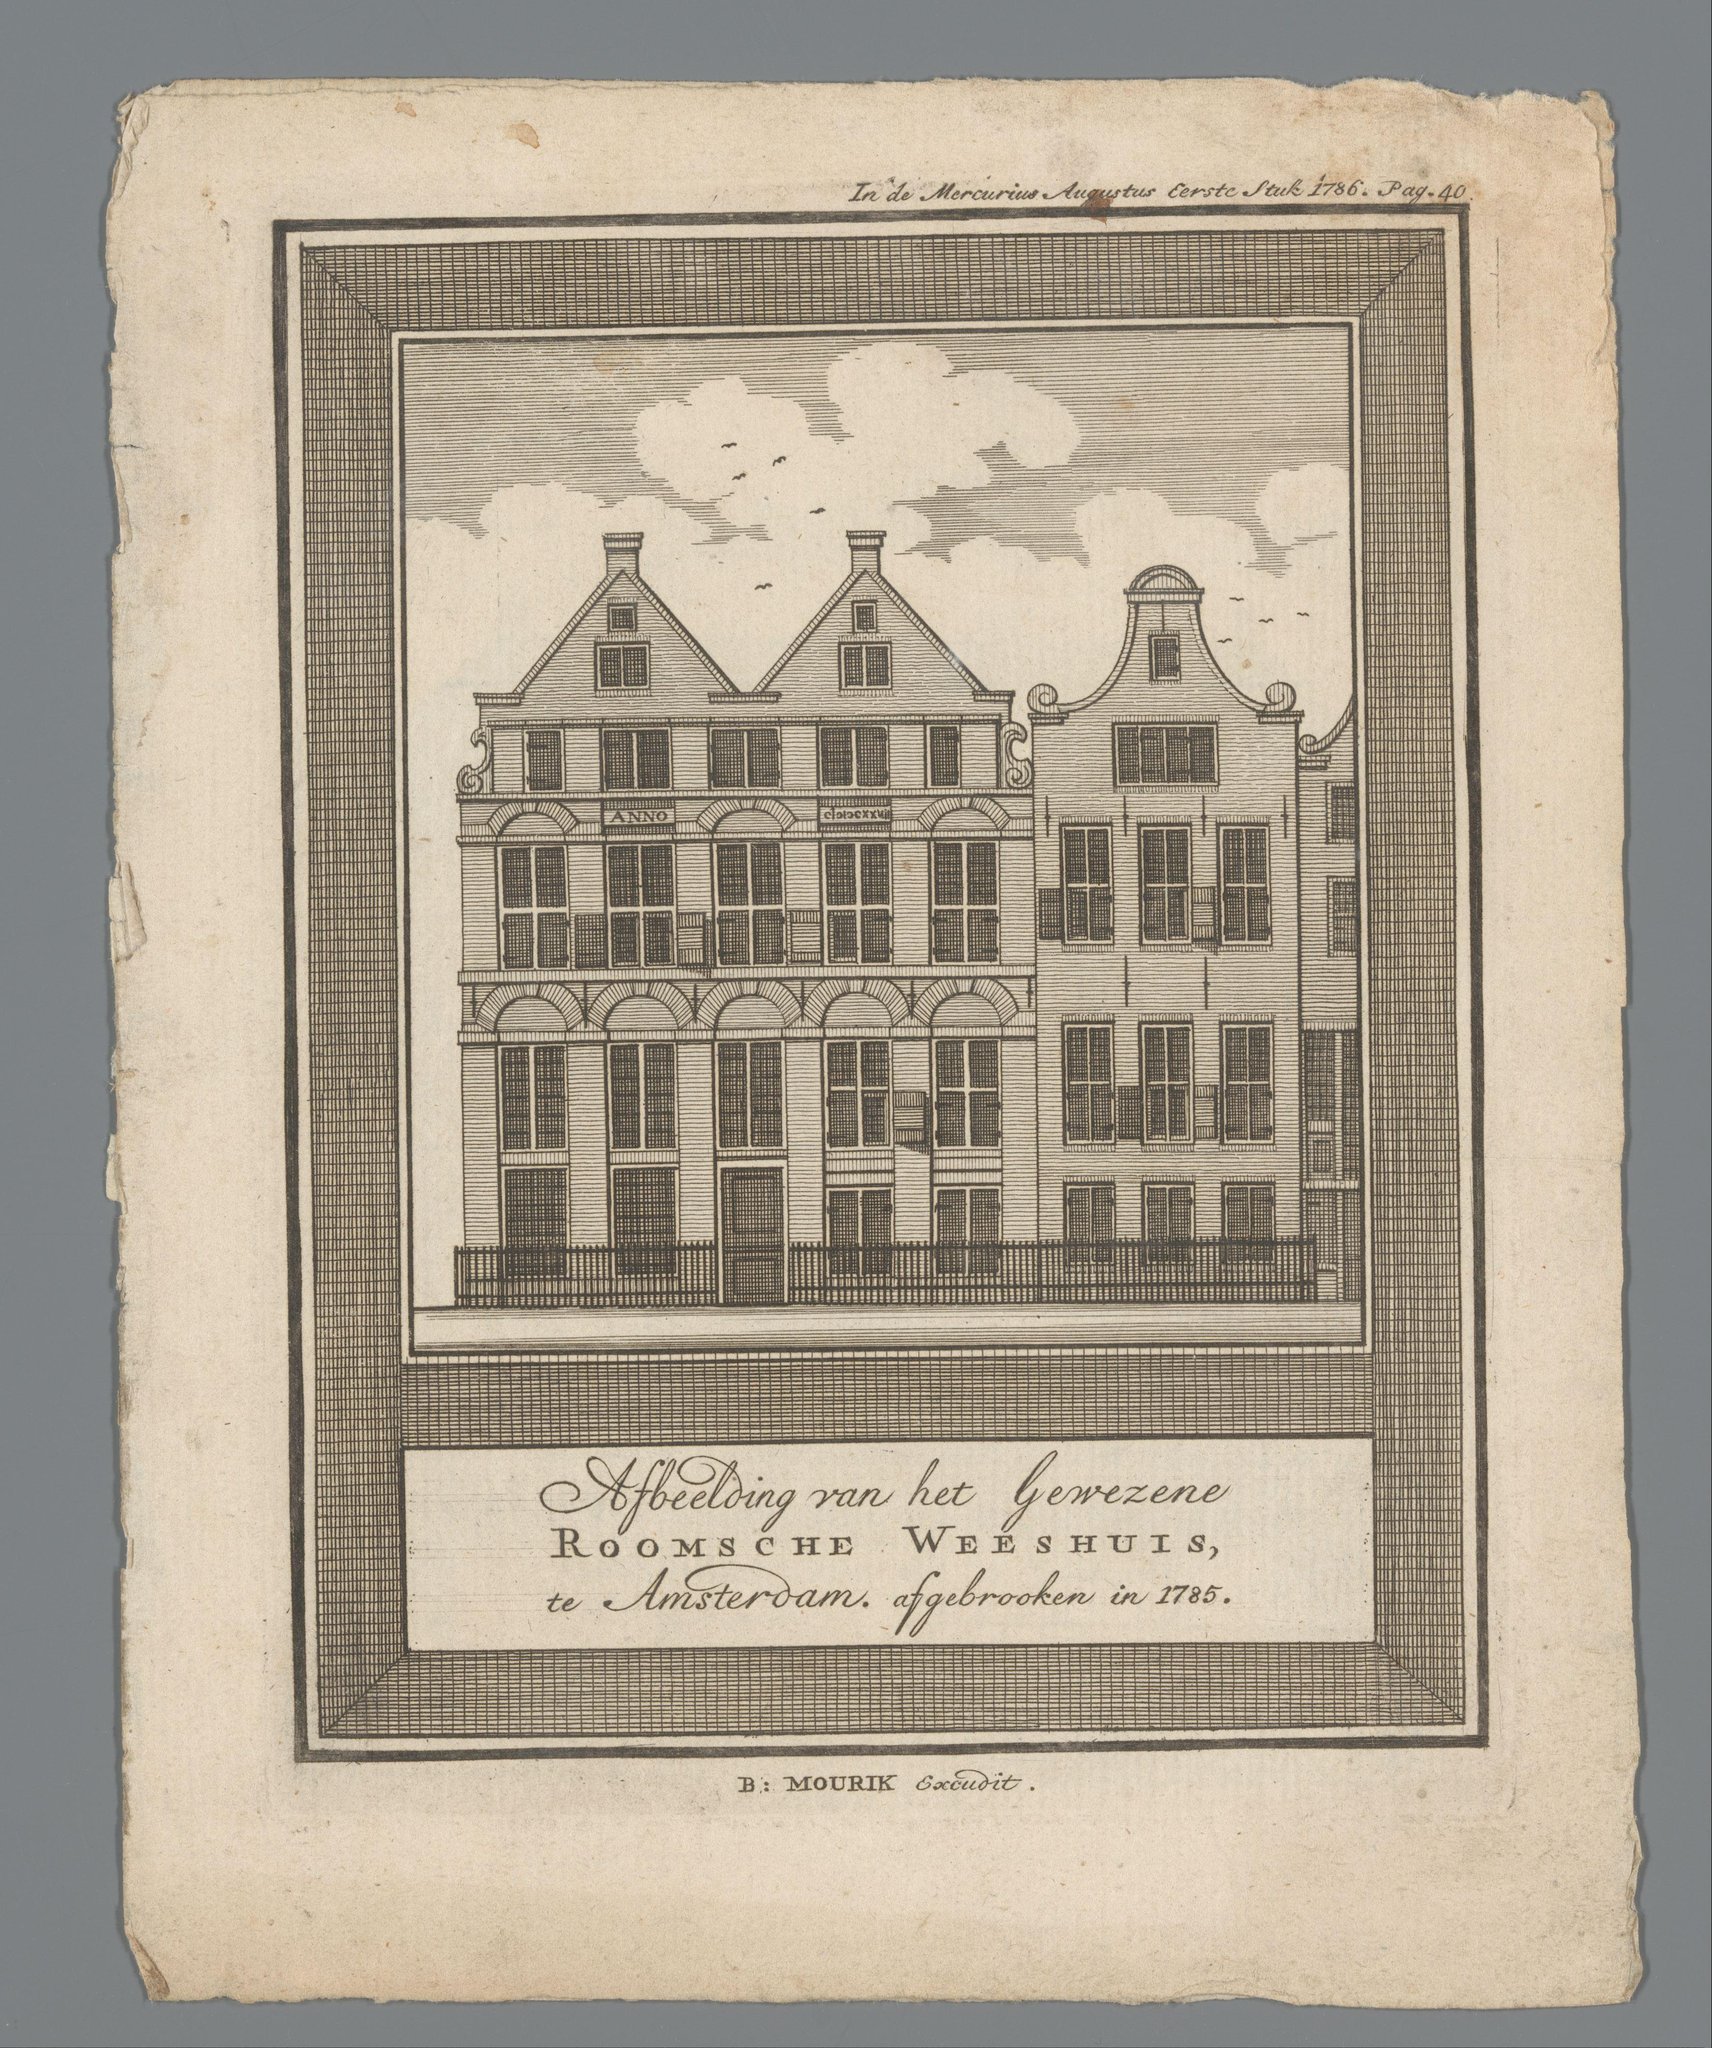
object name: print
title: Afbeelding van het Gewezene Roomsche Weeshuis, te Amsterdam, afgebrooken in 1785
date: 1786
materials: paper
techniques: etching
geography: amsterdam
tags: orphanage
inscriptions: date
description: Prent uit: De Maandelykse Nederlandsche Mercurius (...), augustus 1786, p. 40.